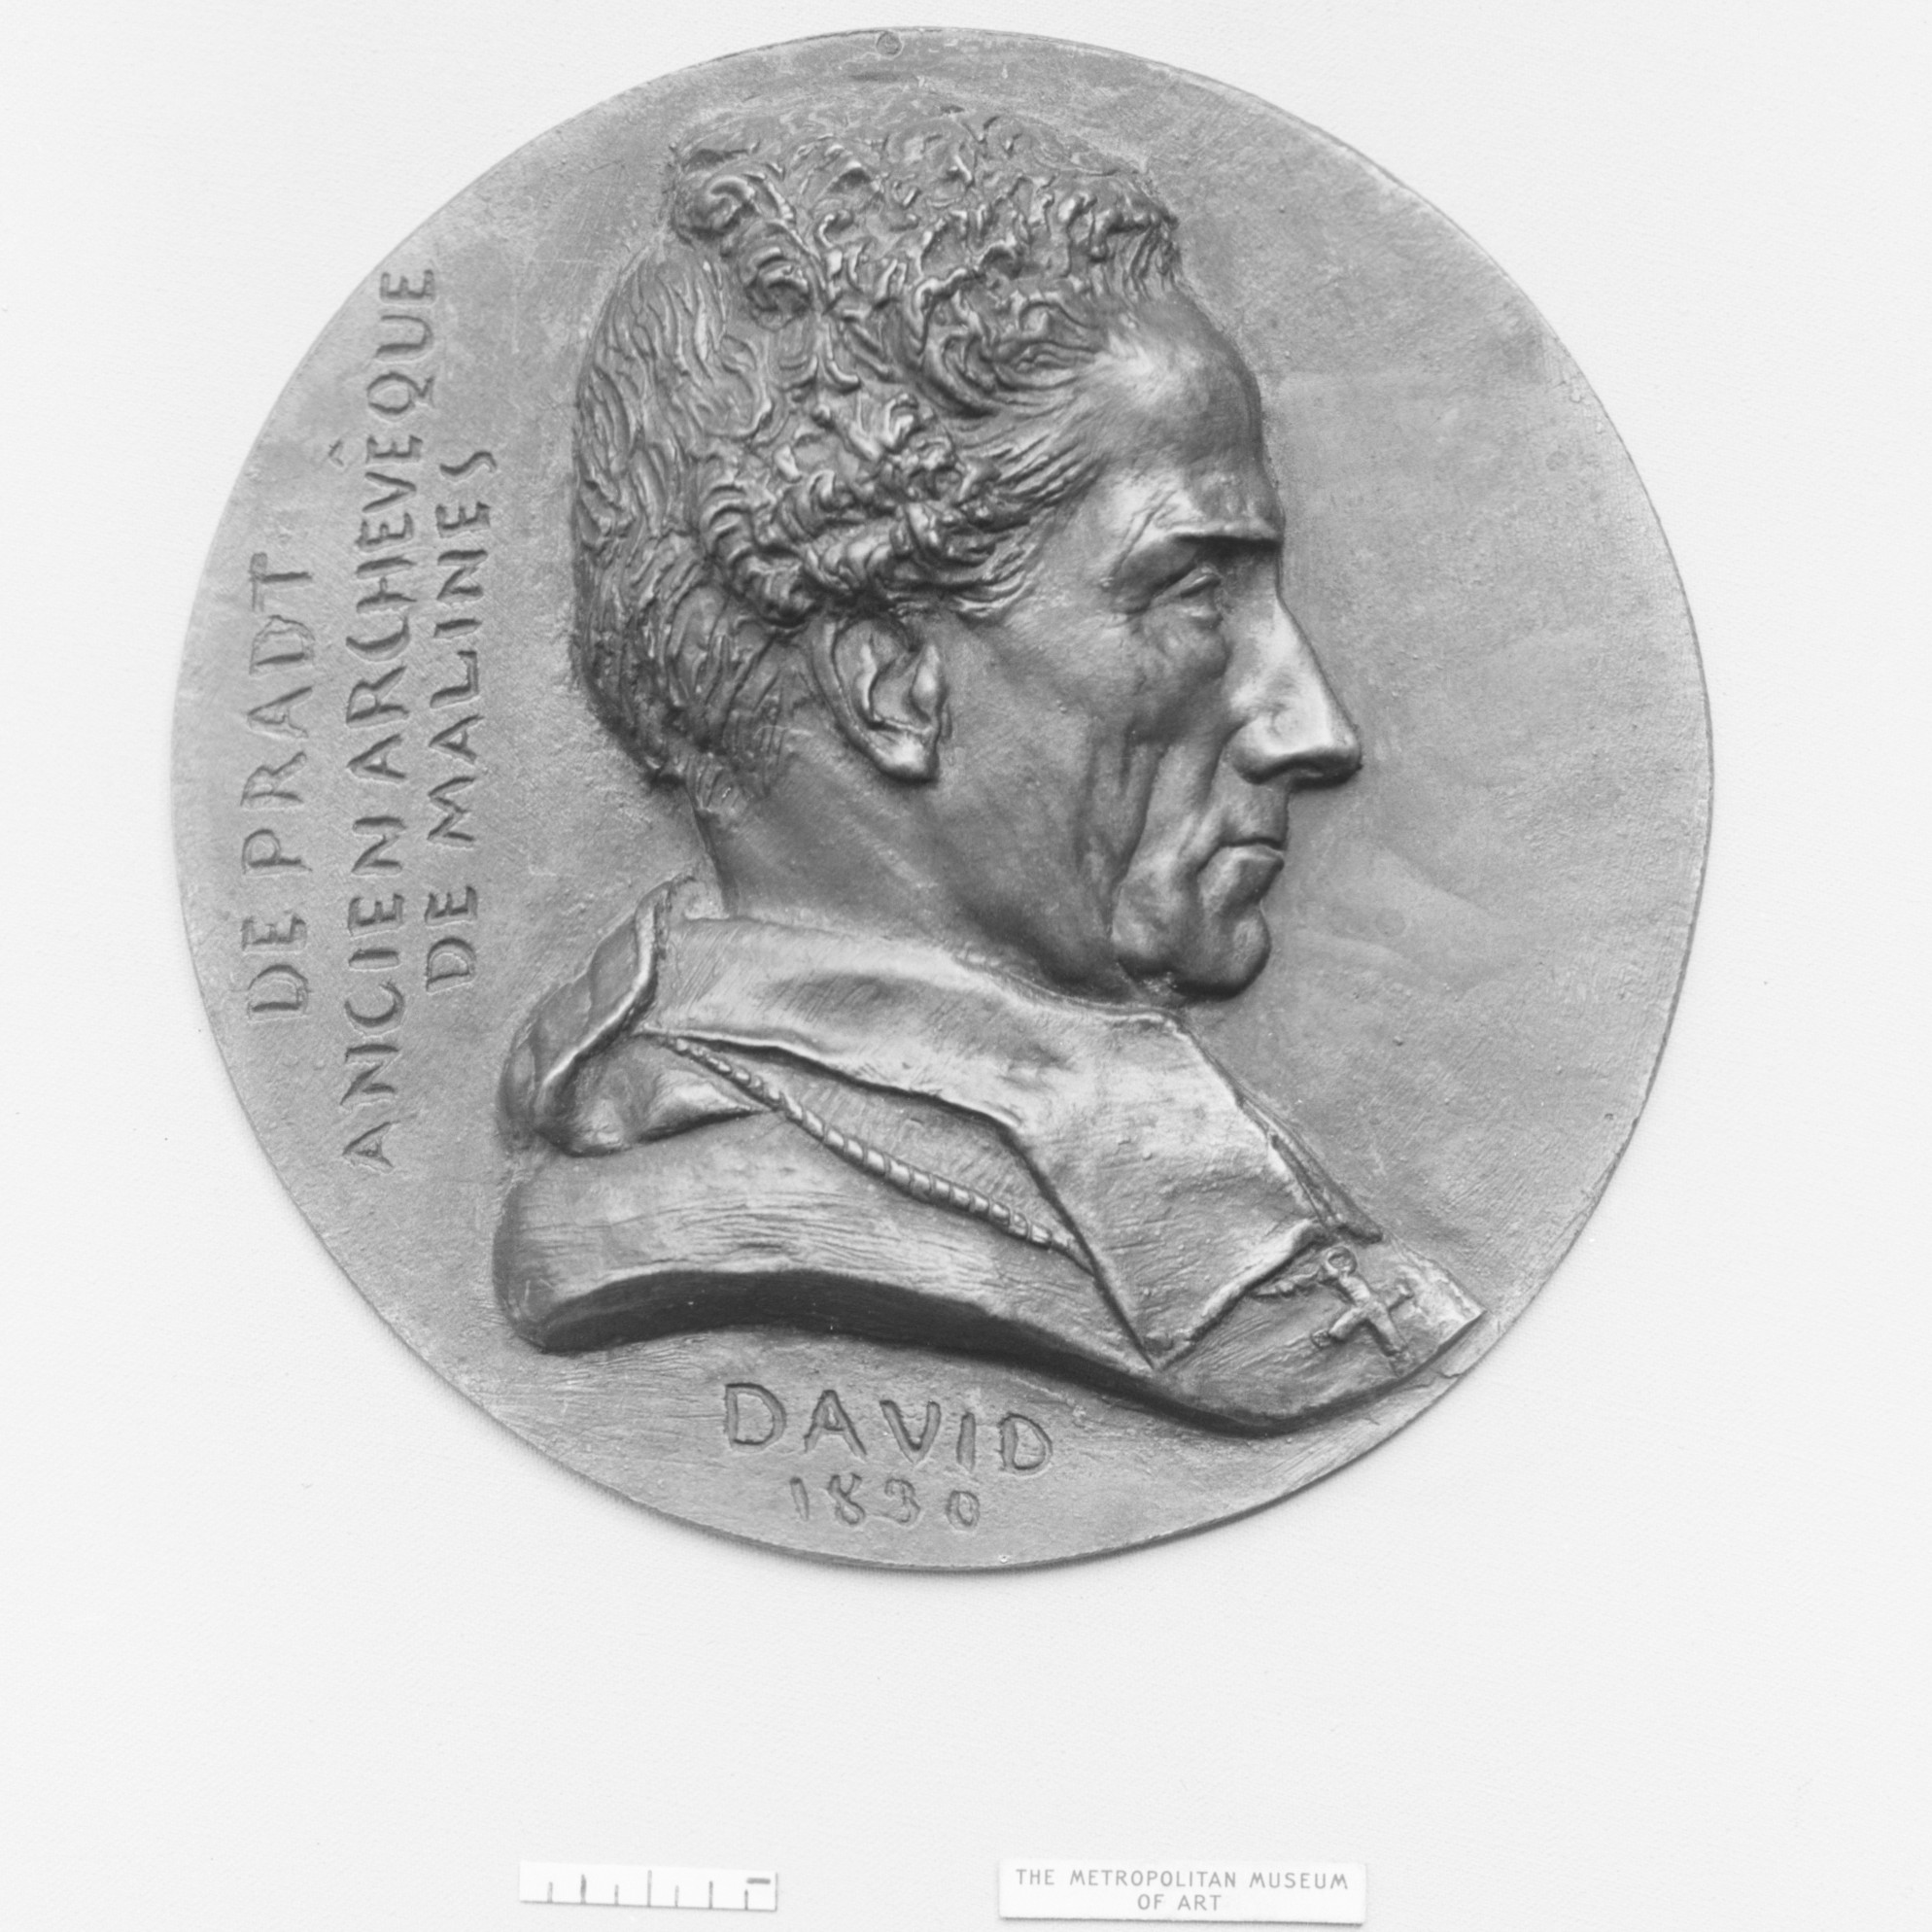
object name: medallion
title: Dominique Dufour, Baron de Pradt (1759–1837), French ecclesiastic and politician, commonly known as the "Abbé de Pradt," though at one time nominated by Bonaparte, for political services, Archbishop of Malines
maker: pierre jean david d'angers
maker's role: artist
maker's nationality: french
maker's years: 1788-1856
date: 1830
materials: bronze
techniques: casting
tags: men,profiles